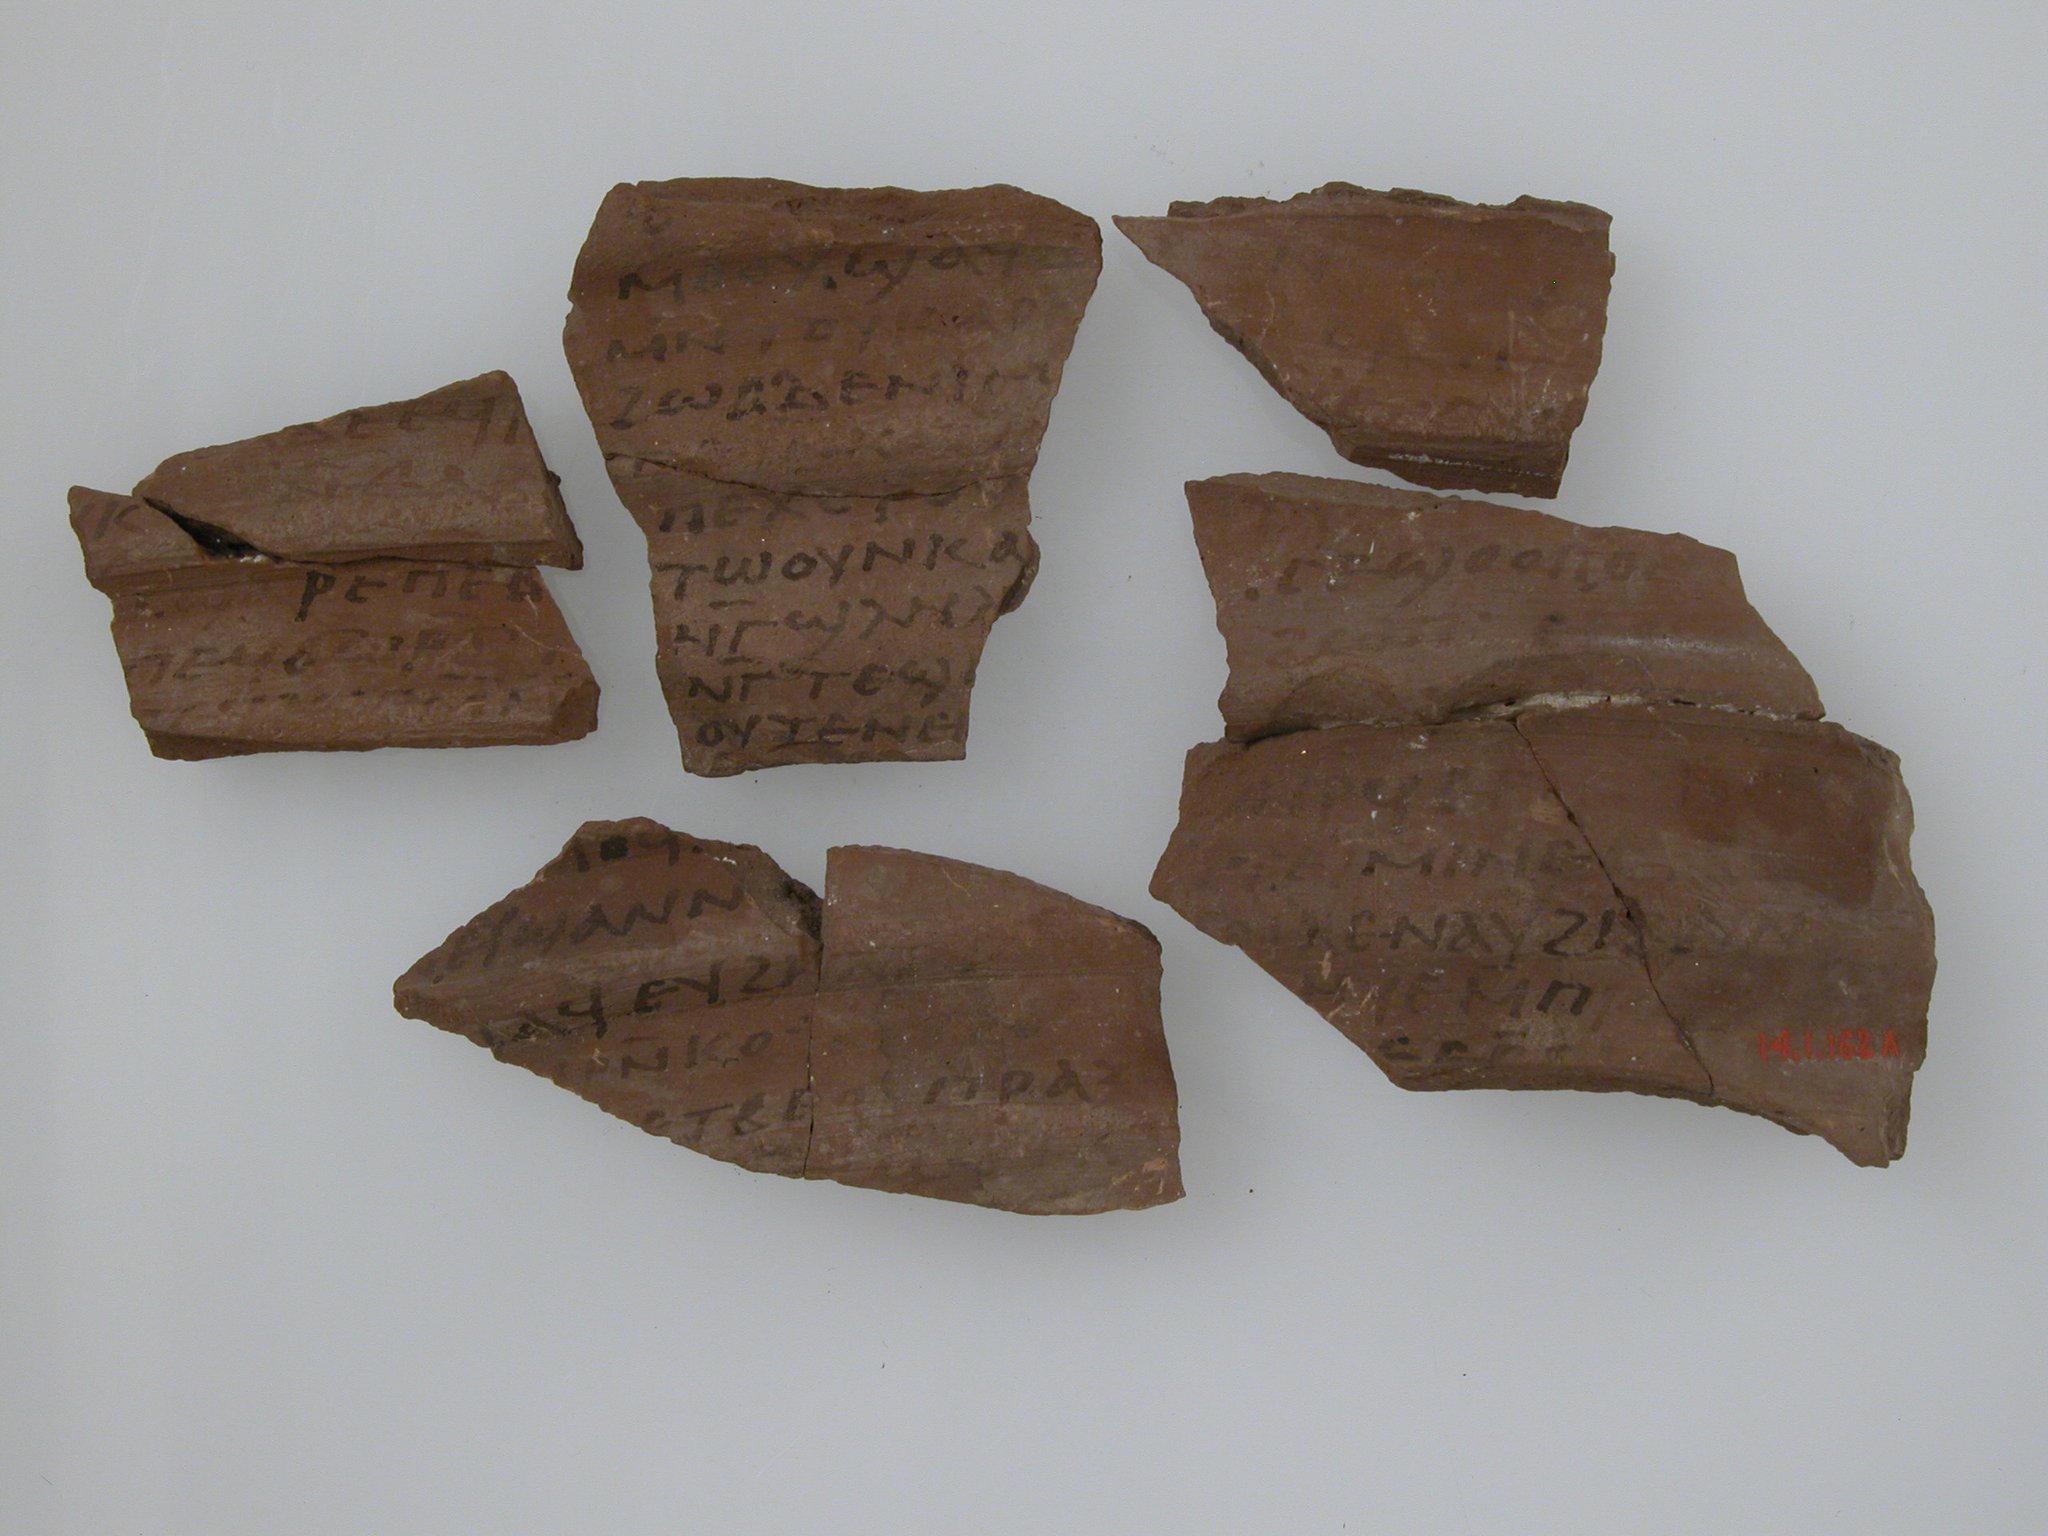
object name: ostrakon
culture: coptic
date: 600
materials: ink, pottery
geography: egypt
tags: coptic,documents